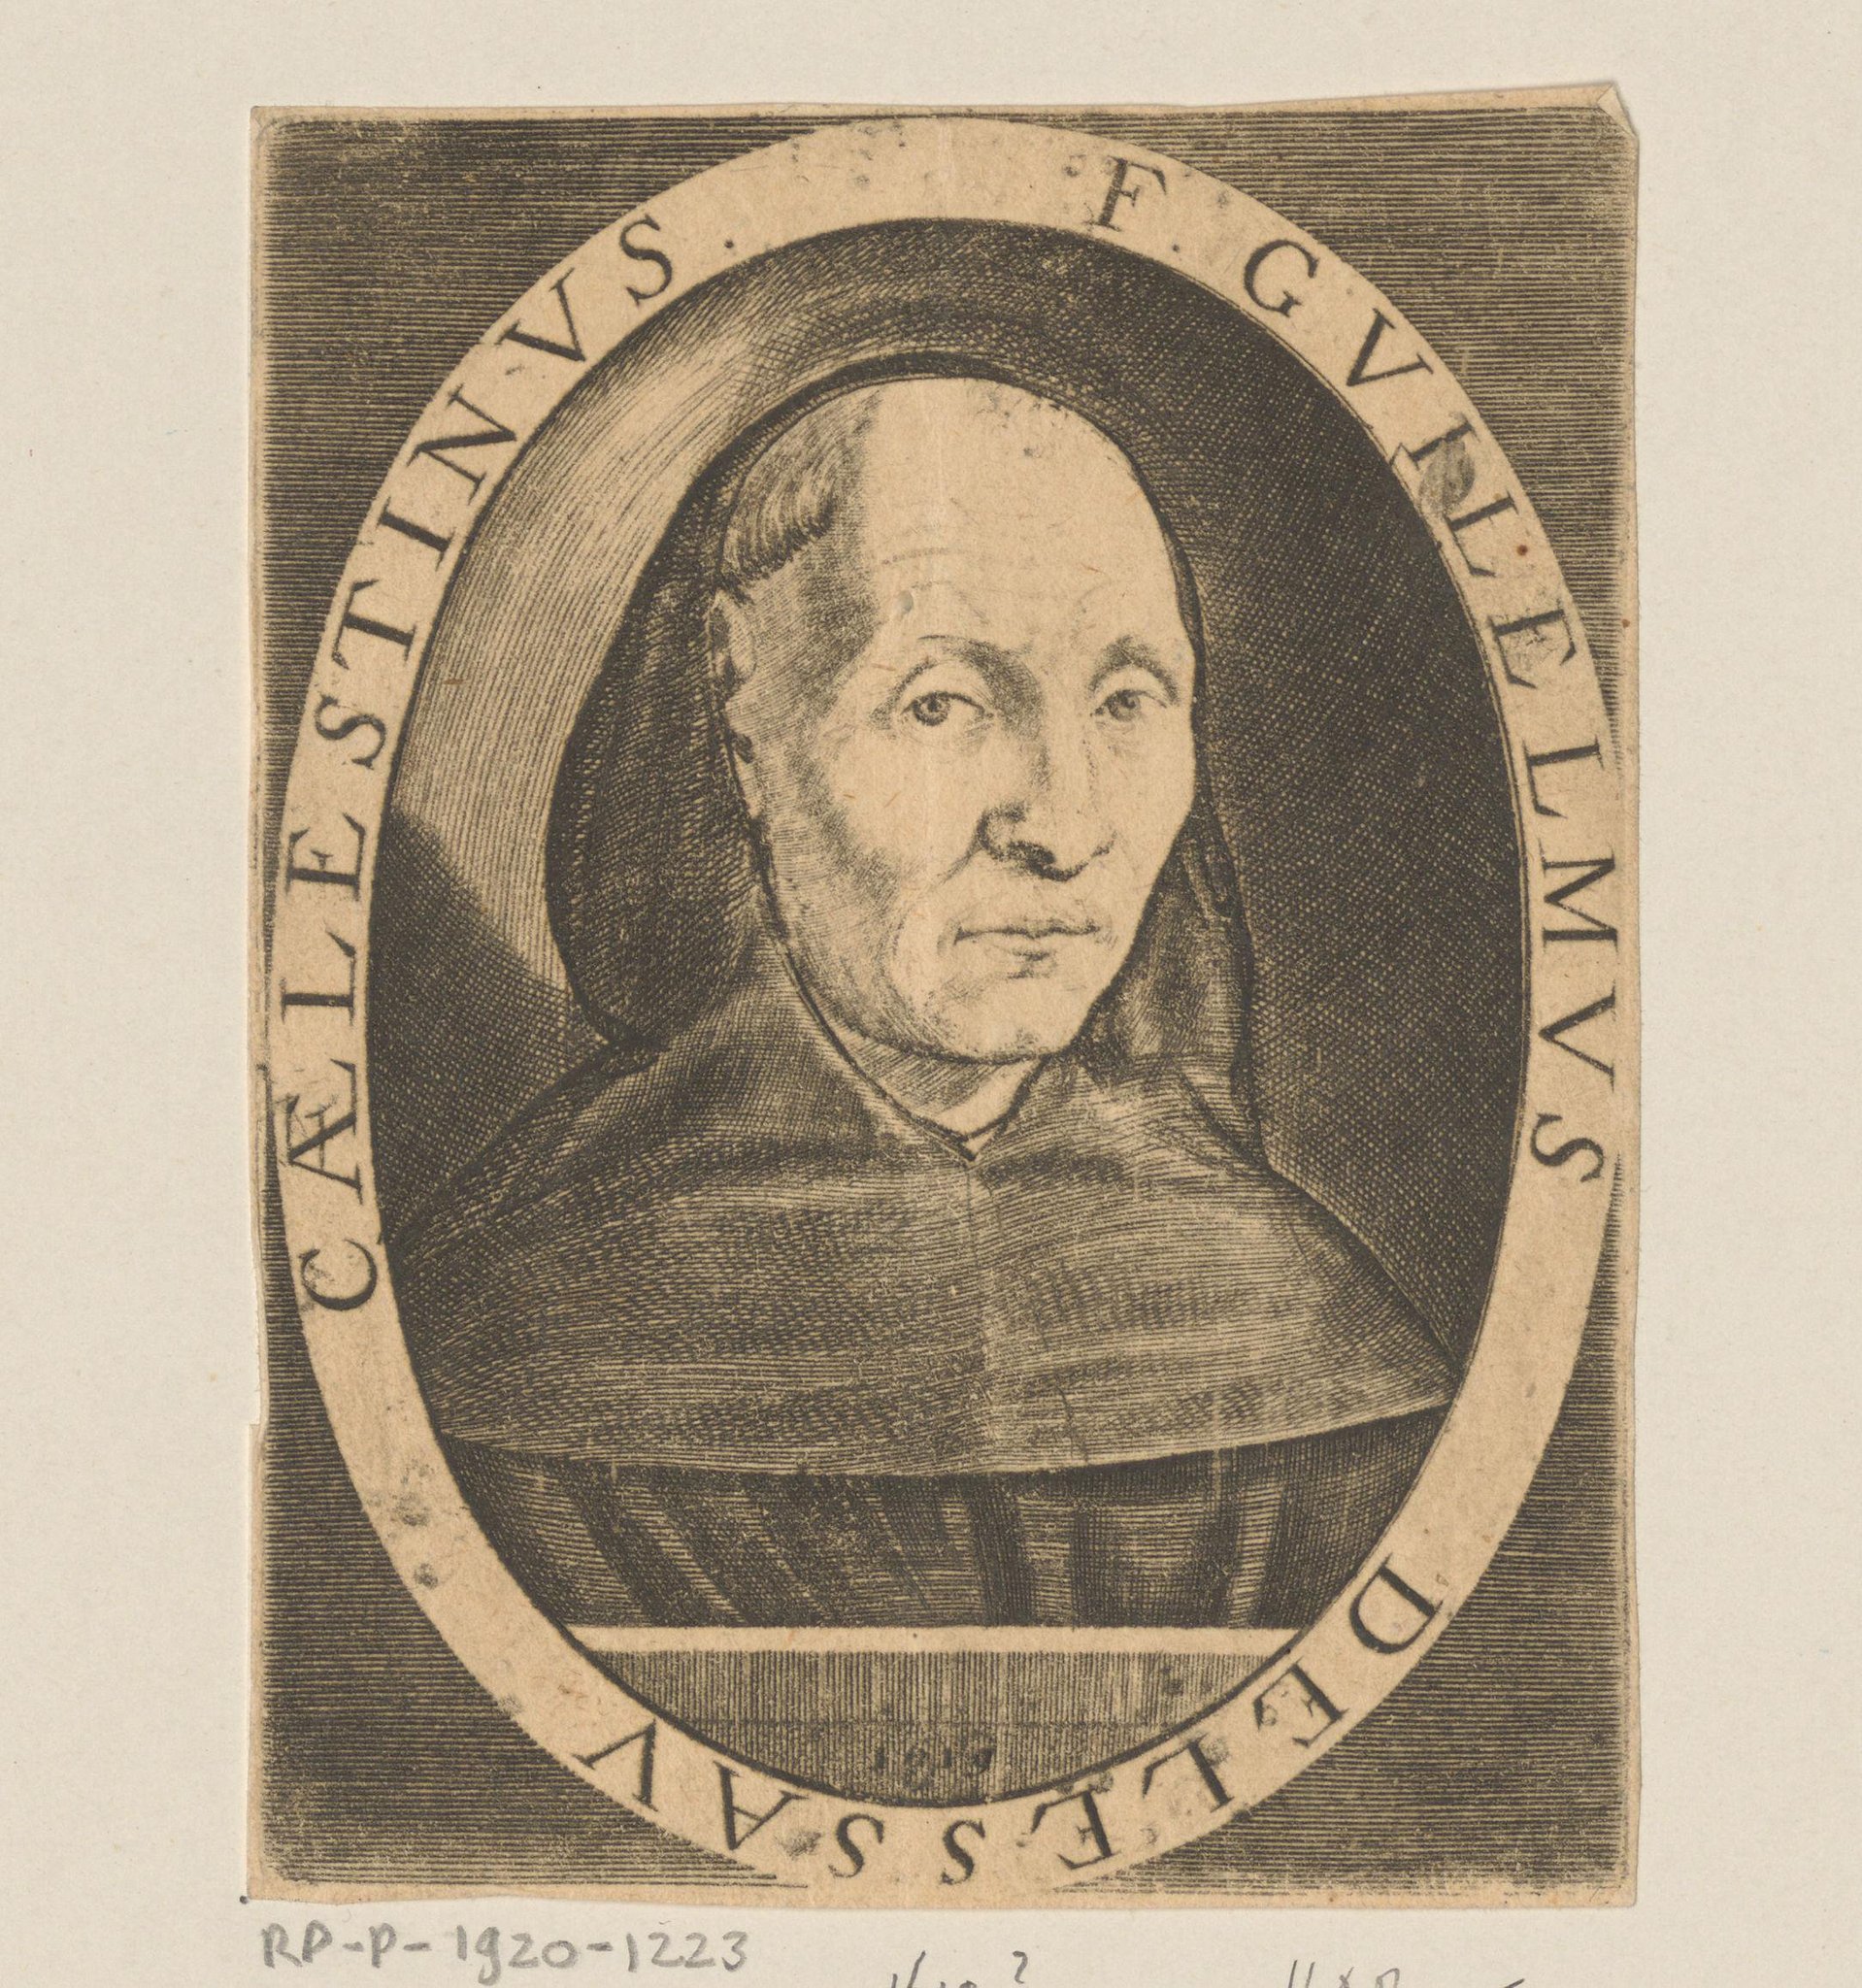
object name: print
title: Portret van Guillaume Delessau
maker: Anonymous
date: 1619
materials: paper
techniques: engraving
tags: historical persons, portrait of a writer, writer, poet, author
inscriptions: collector's mark: Lugt 2228